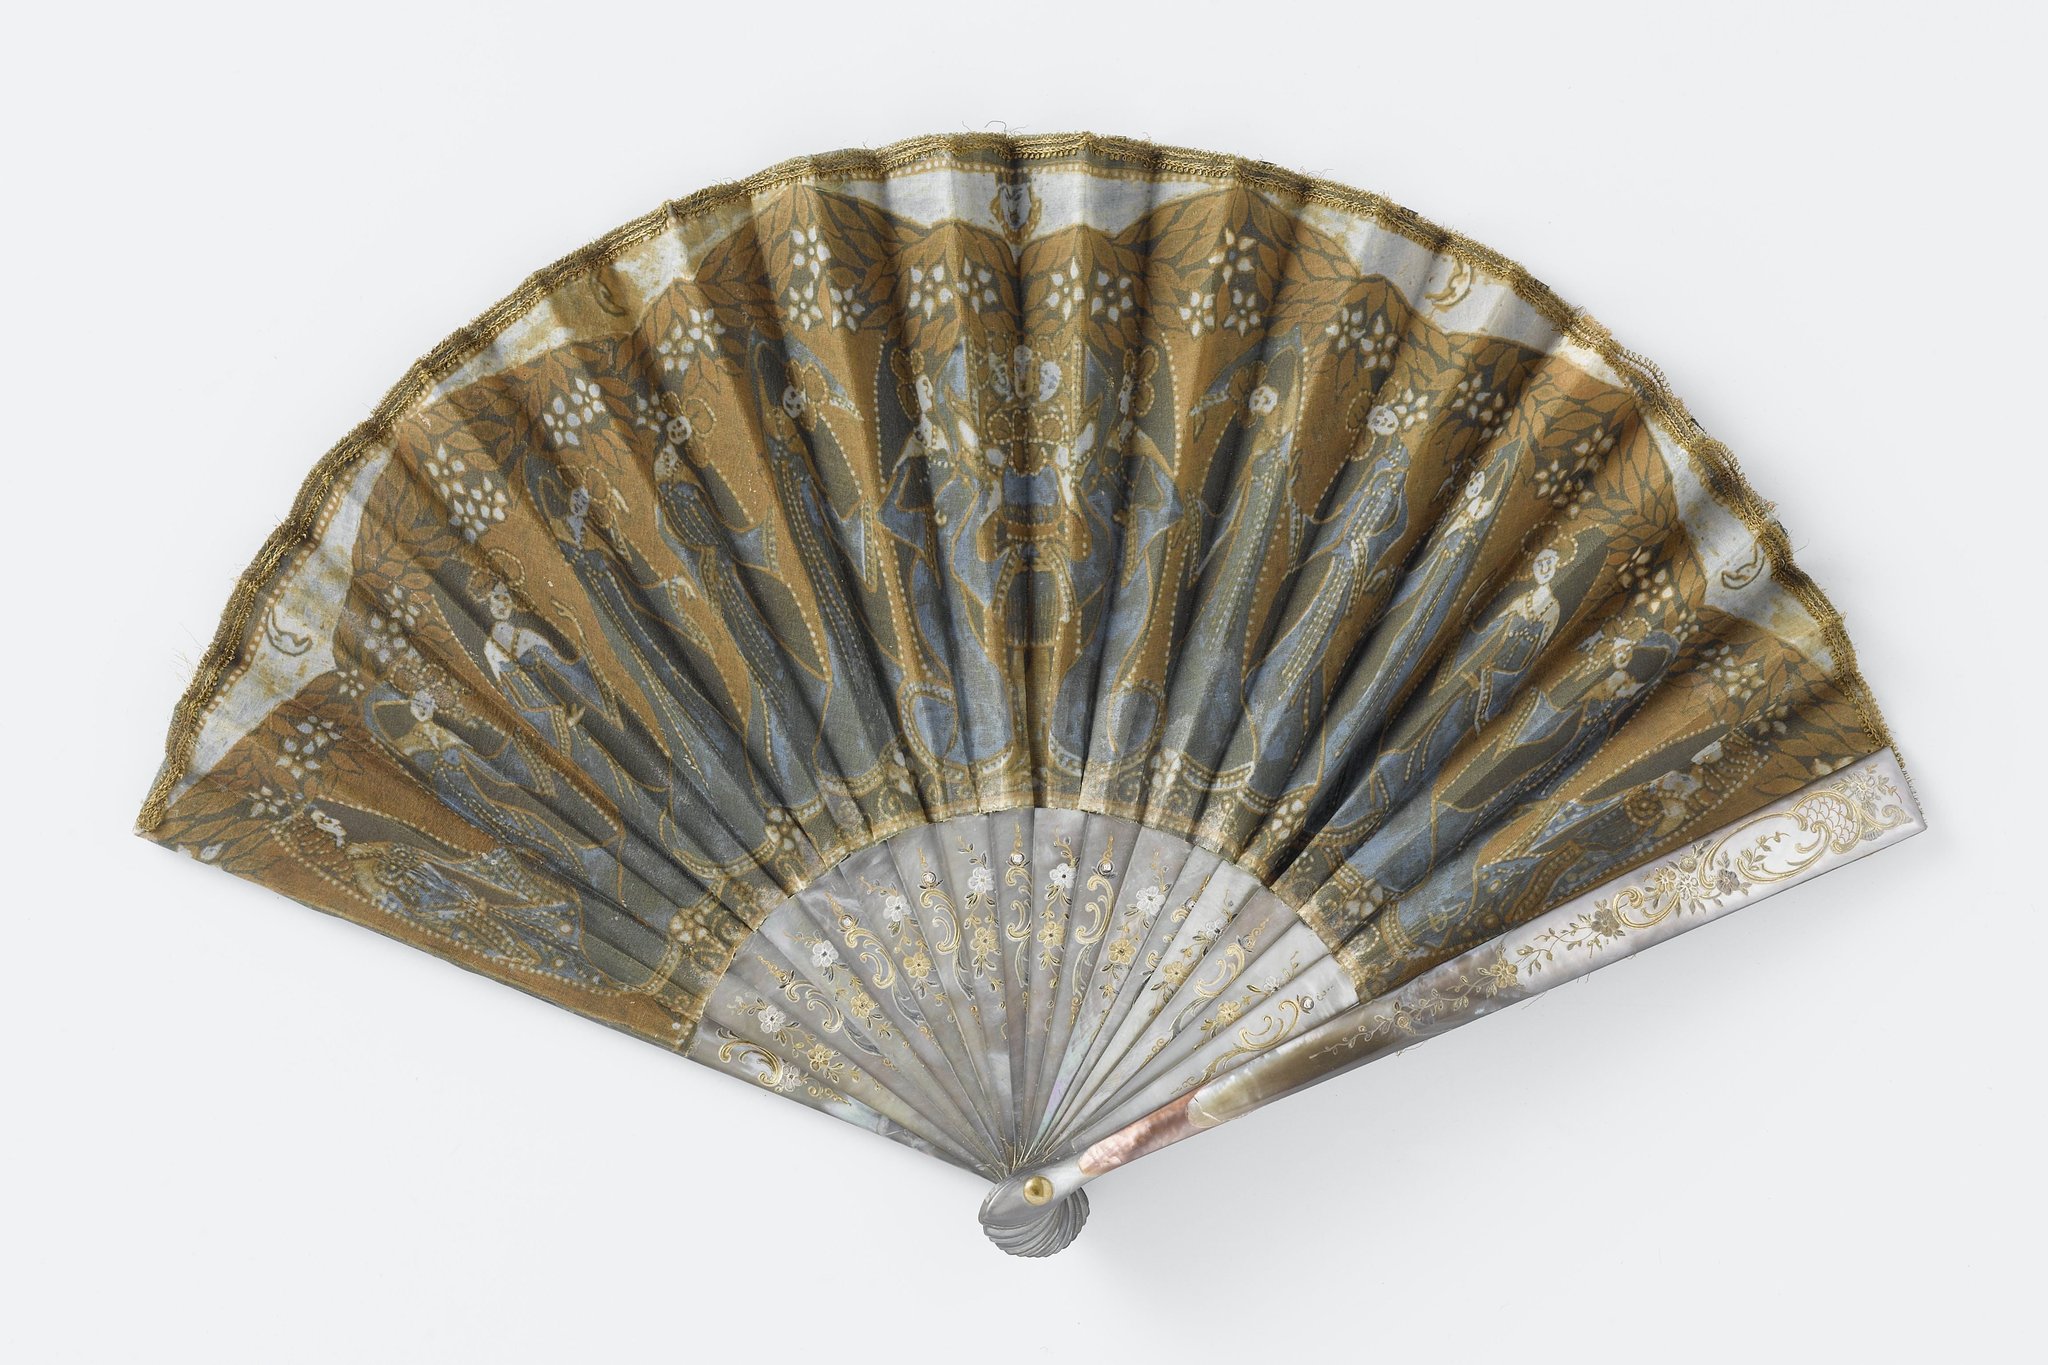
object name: vouwwaaier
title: Vouwwaaier met gebatikt blad, waarop een voorstelling met 15 figuren, op een montuur van parelmoer ingelegd met goud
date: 1907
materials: cotton, textile, gold, mother of pearl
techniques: cutting, inlay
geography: netherlands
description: Vouwwaaier met gebatikt voorblad in blauwbruine kleuren, waarop een symmetrische voorstelling met 15 figuren. De centrale figuur met drie hoofden, heeft aan weerskanten staande figuren die een buigende beweging maken. Boven de figuren zijn bloemen en vier halve manen. Het achterblad is van een groene crêpe. Het montuur telt 18 benen van parelmoer met geel en wit bladgoud ingelegde bloemen en c-voluten, de achterkant is onbewerkt. De sluitpin is van koper.